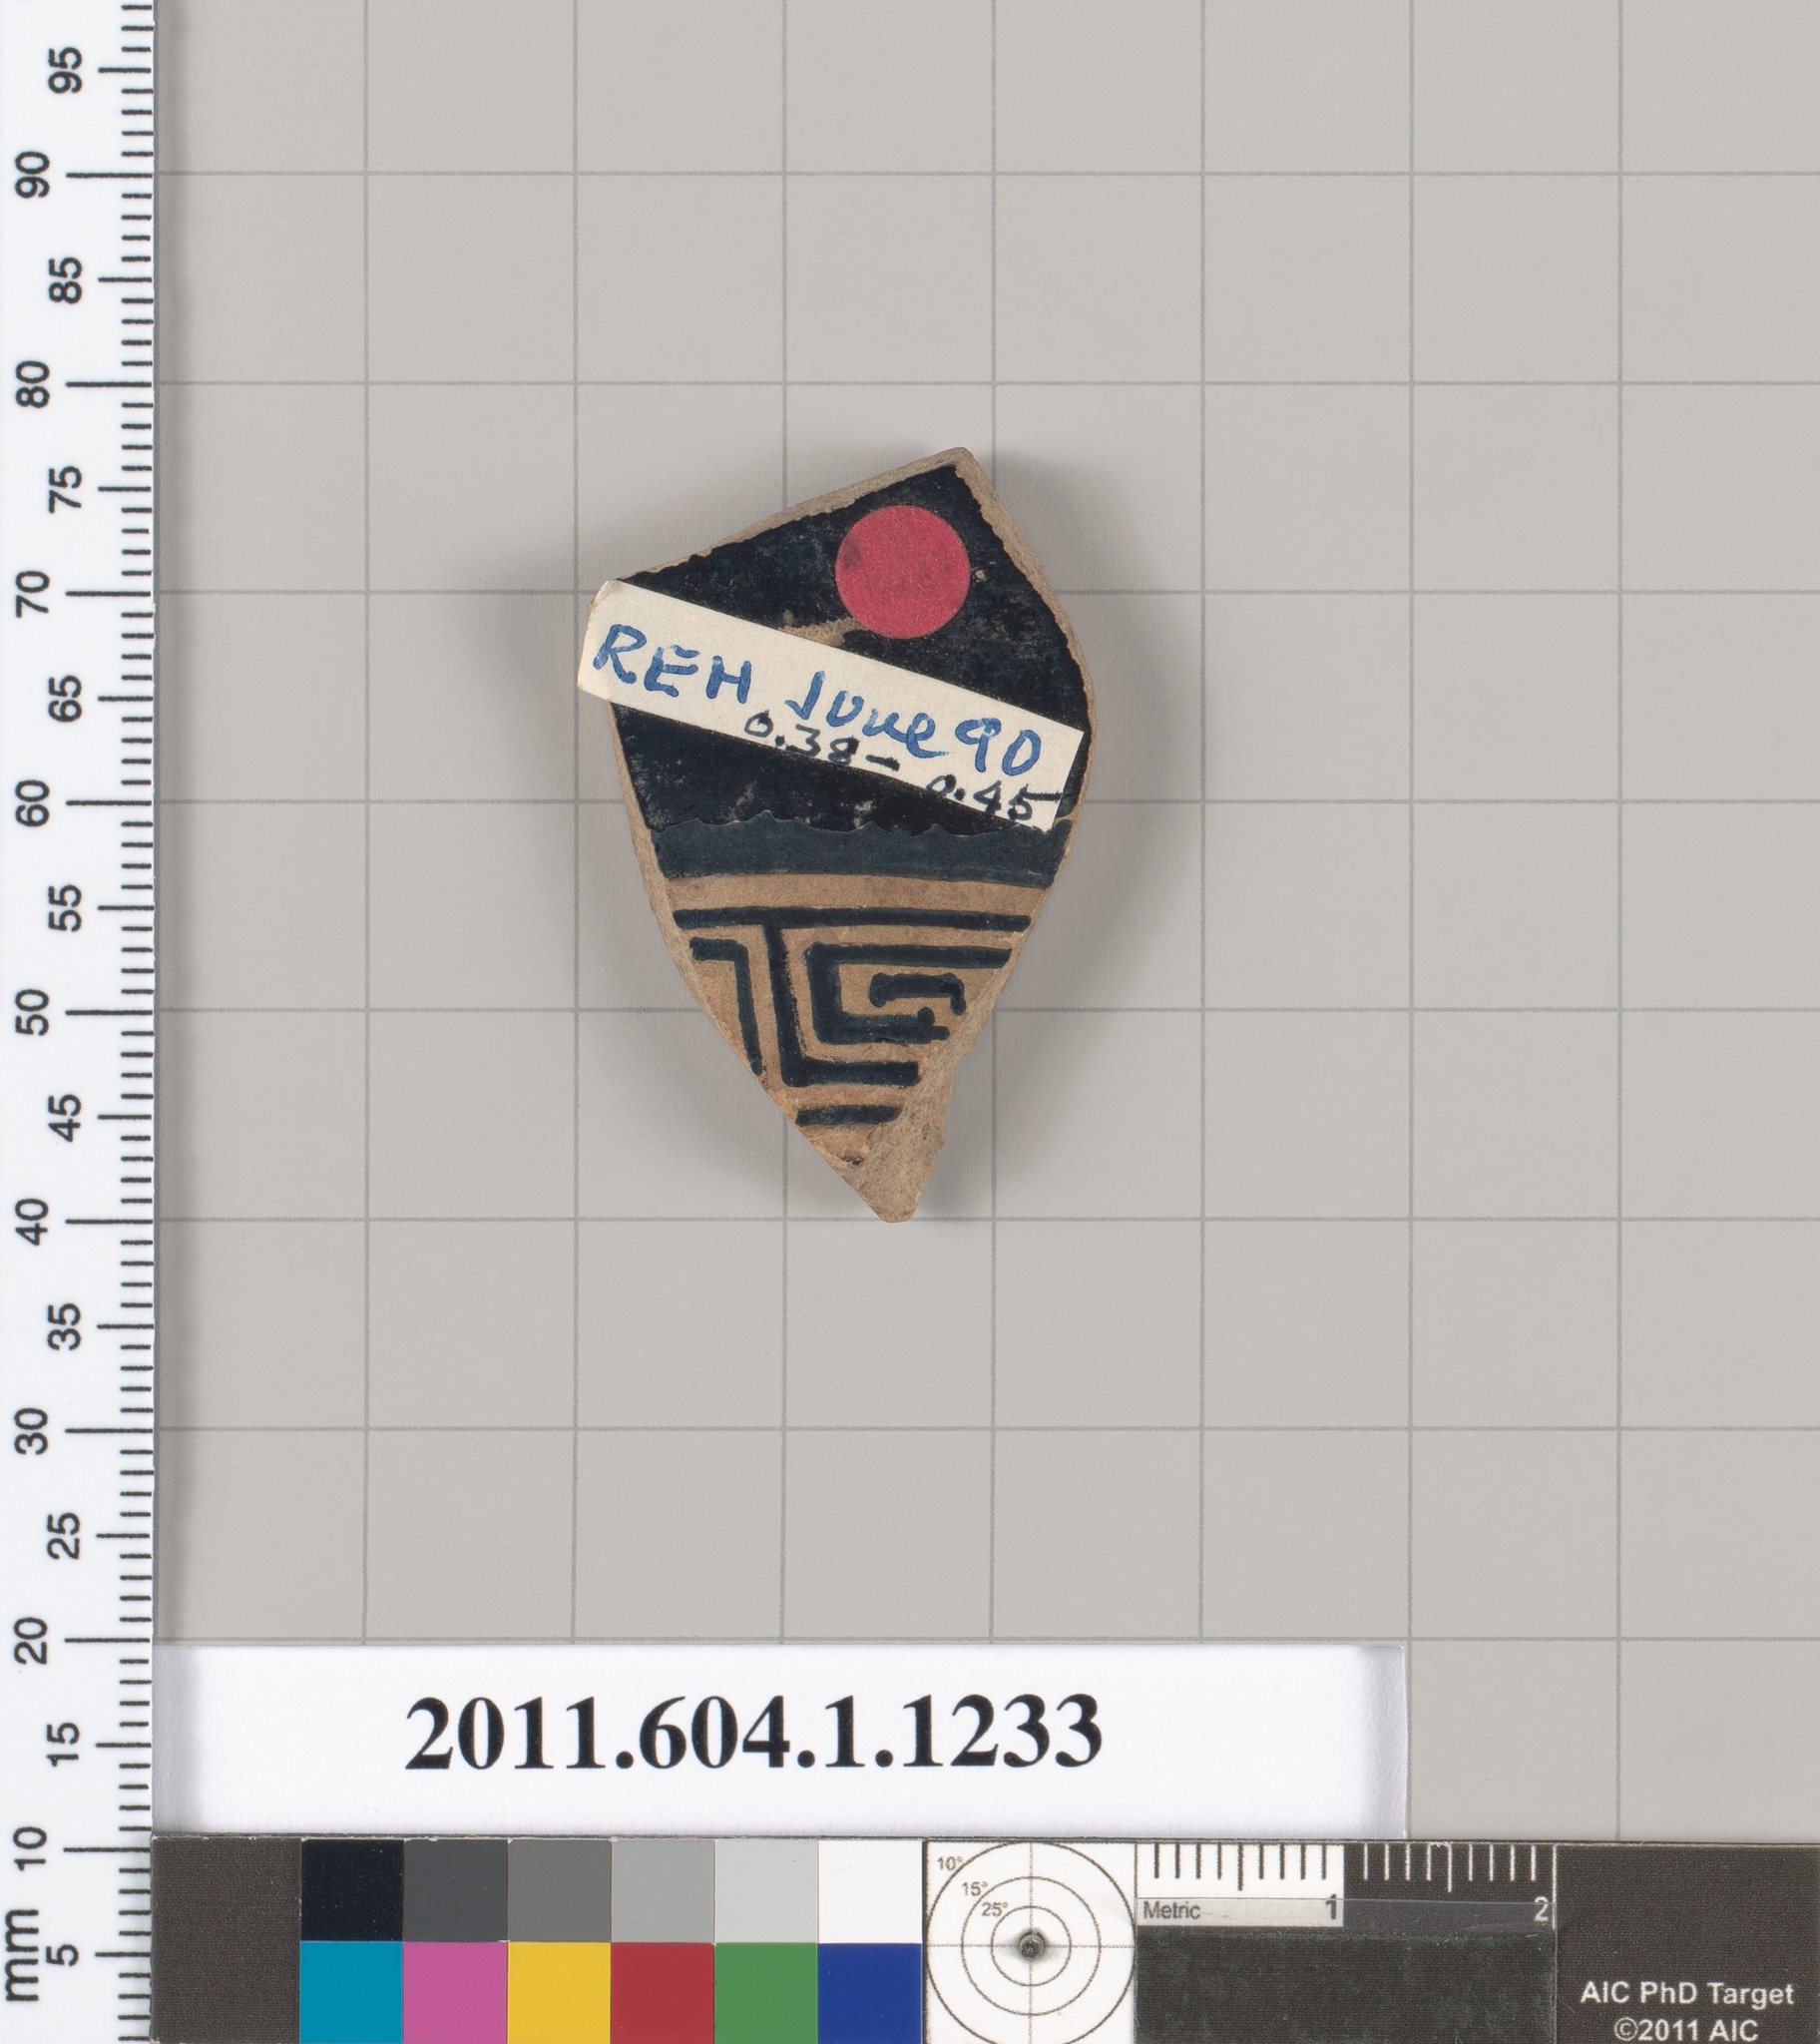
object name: kylix fragment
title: Terracotta fragment of a kylix (drinking cup)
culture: greek, attic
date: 475-451 BCE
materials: terracotta